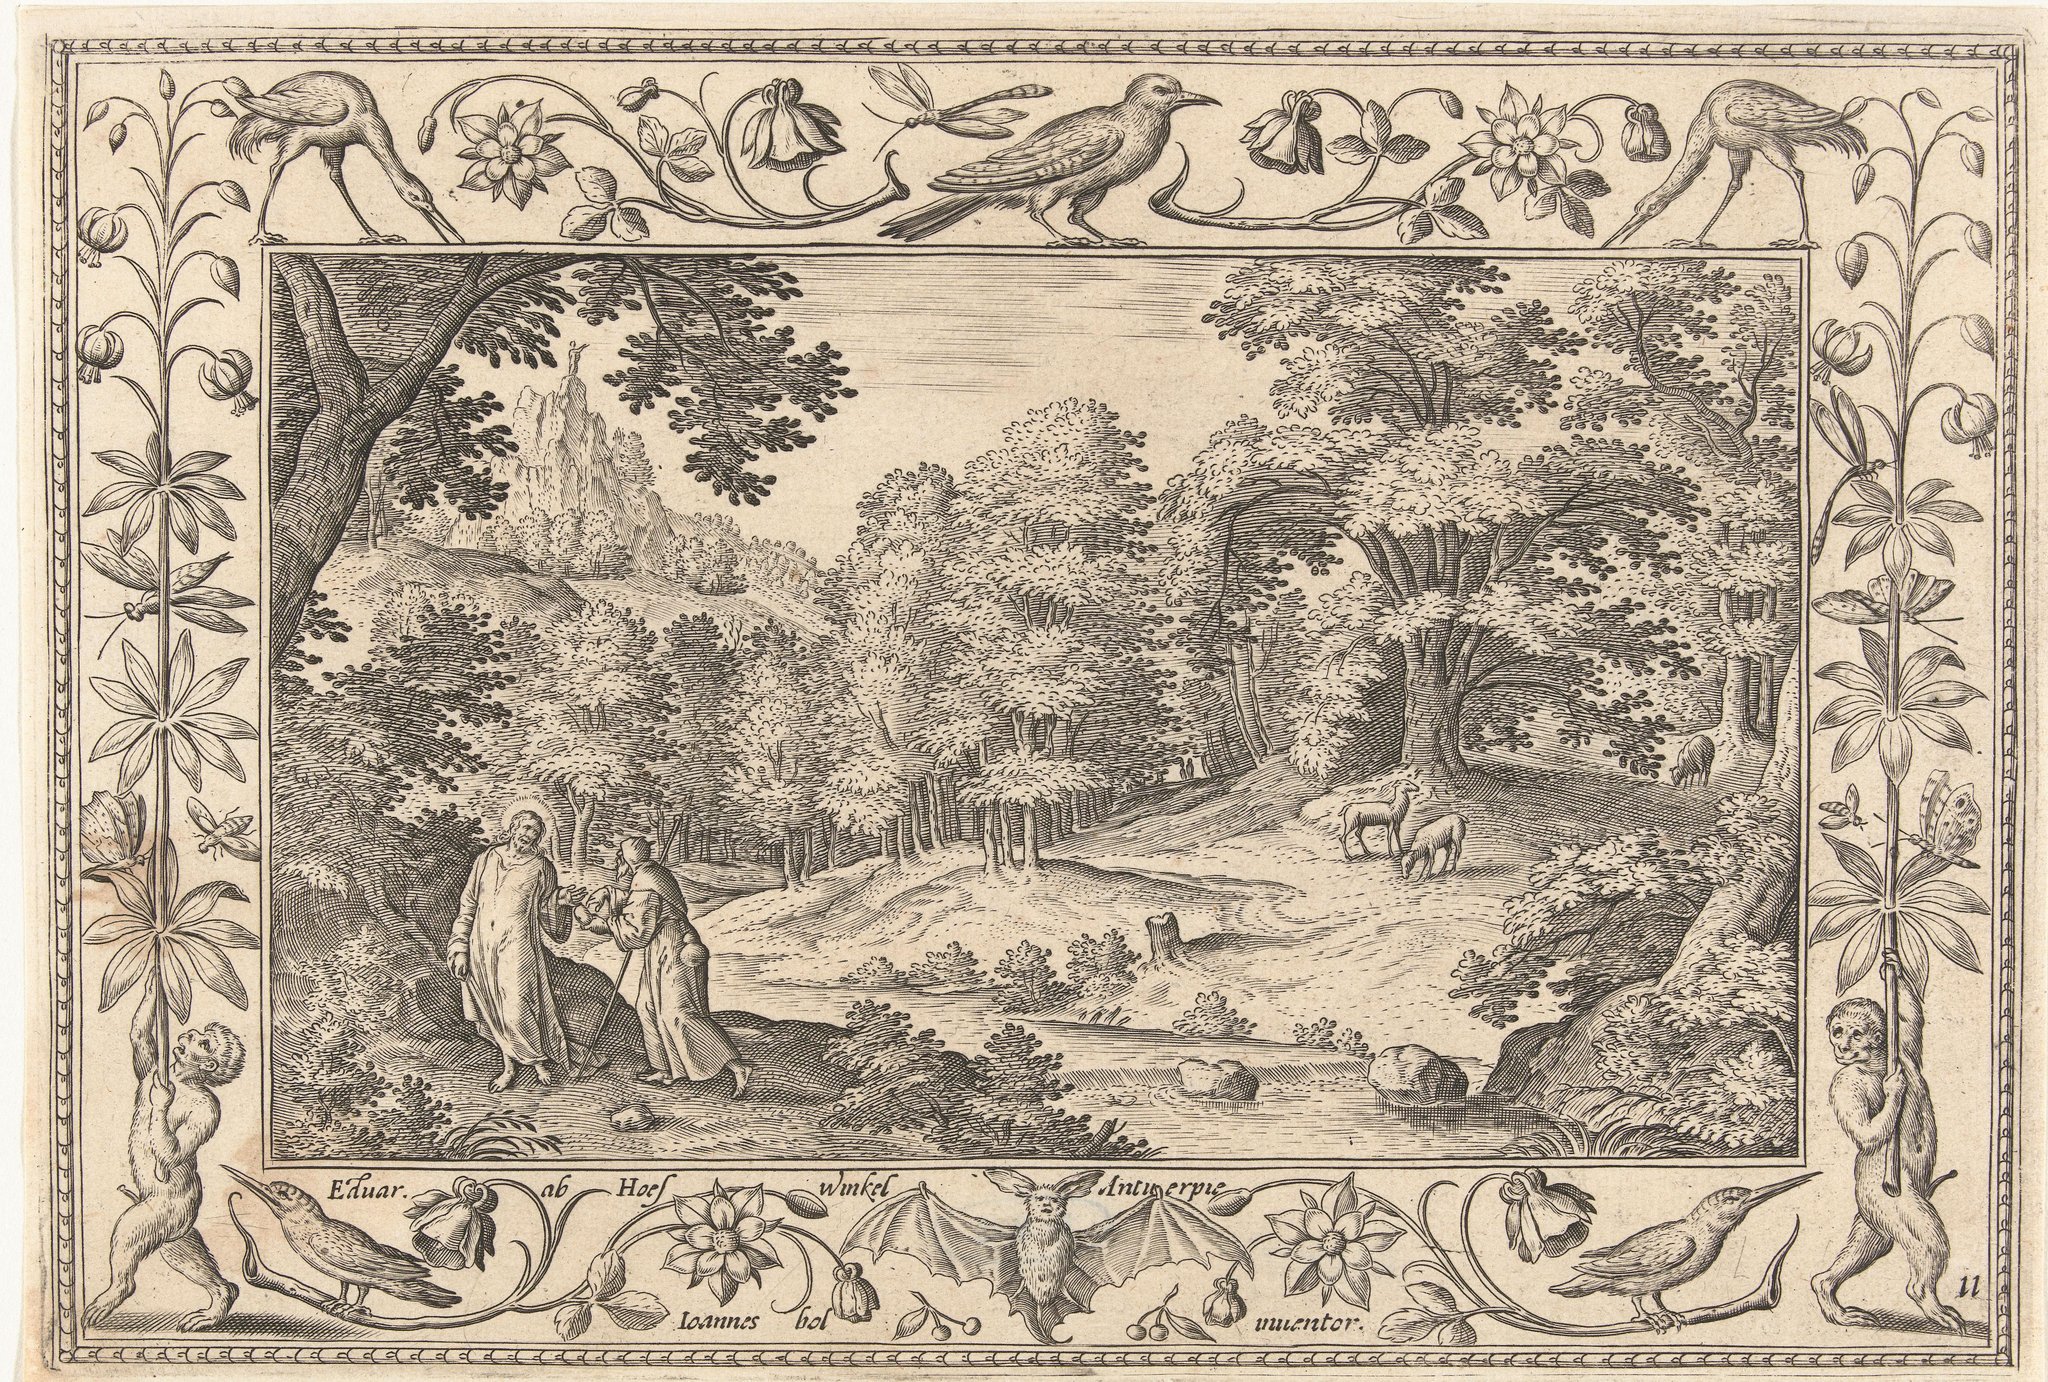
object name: print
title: Verzoeking in de woestijn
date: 1582-1586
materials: paper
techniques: engraving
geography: antwerp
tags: 'command these stones to become loaves of bread' ~ temptation of christ in the wilderness, ornamental birds, forest, wood, 'all these will i give you' (= the glory of the world) ~ temptation of christ in the wilderness, monkeys, apes (+ ornamental variants of animals), flying mammals: bat (+ ornamental variants of animals), flowers ~ ornament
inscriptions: collector's mark: Lugt 2228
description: Boslandschap. Op de voorgrond verzoekt de duivel Christus twee stenen in broden te veranderen. Op de achtergrond de bergtop waar Satan Christus voor een derde keer op de proef stelt. De prent heeft een ornamentlijst met bloemen en dieren. Hij maakt deel uit van een vierentwintigdelige serie van landschappen met Bijbelse, mythologische scènes en jachttaferelen.